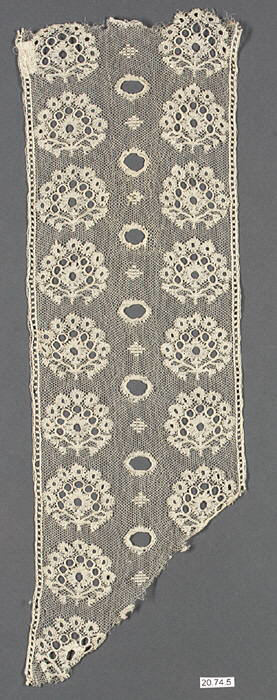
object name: piece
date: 1801-1833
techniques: lace